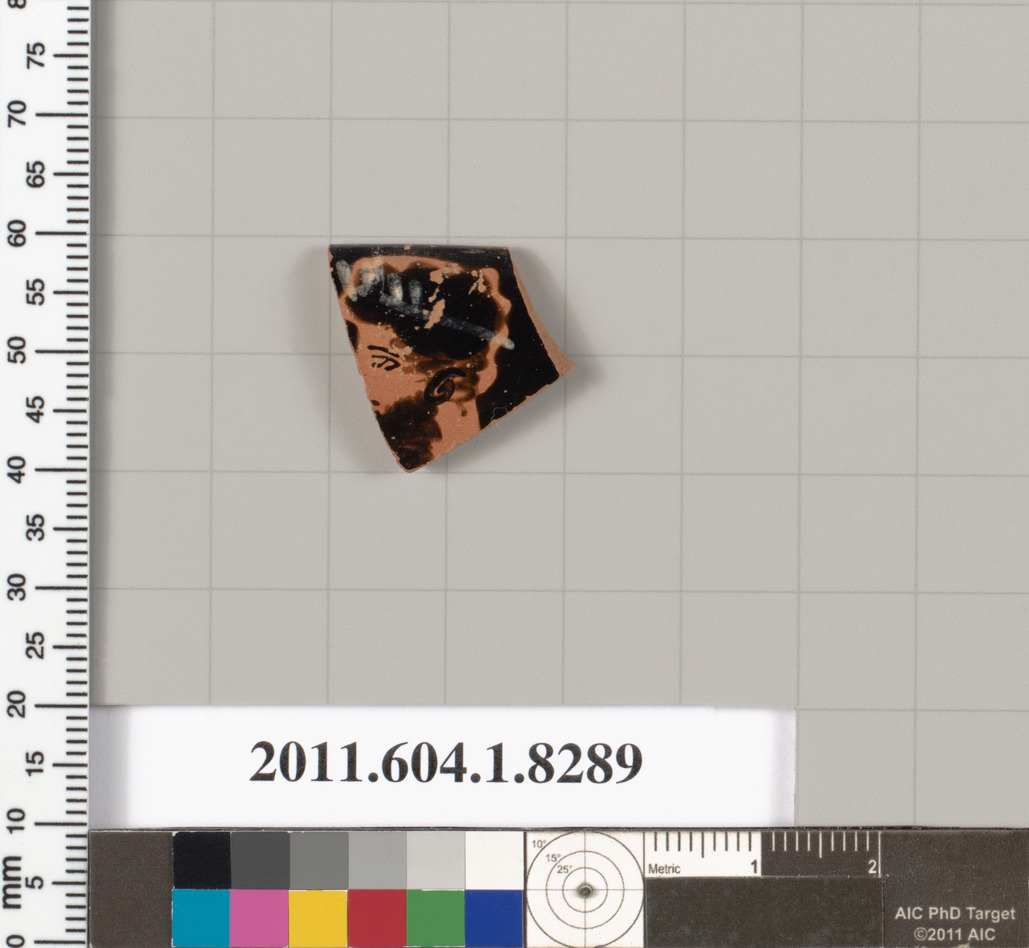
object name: kylix fragment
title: Terracotta rim fragment of a kylix (drinking cup)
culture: greek, attic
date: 400-376 BCE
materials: terracotta